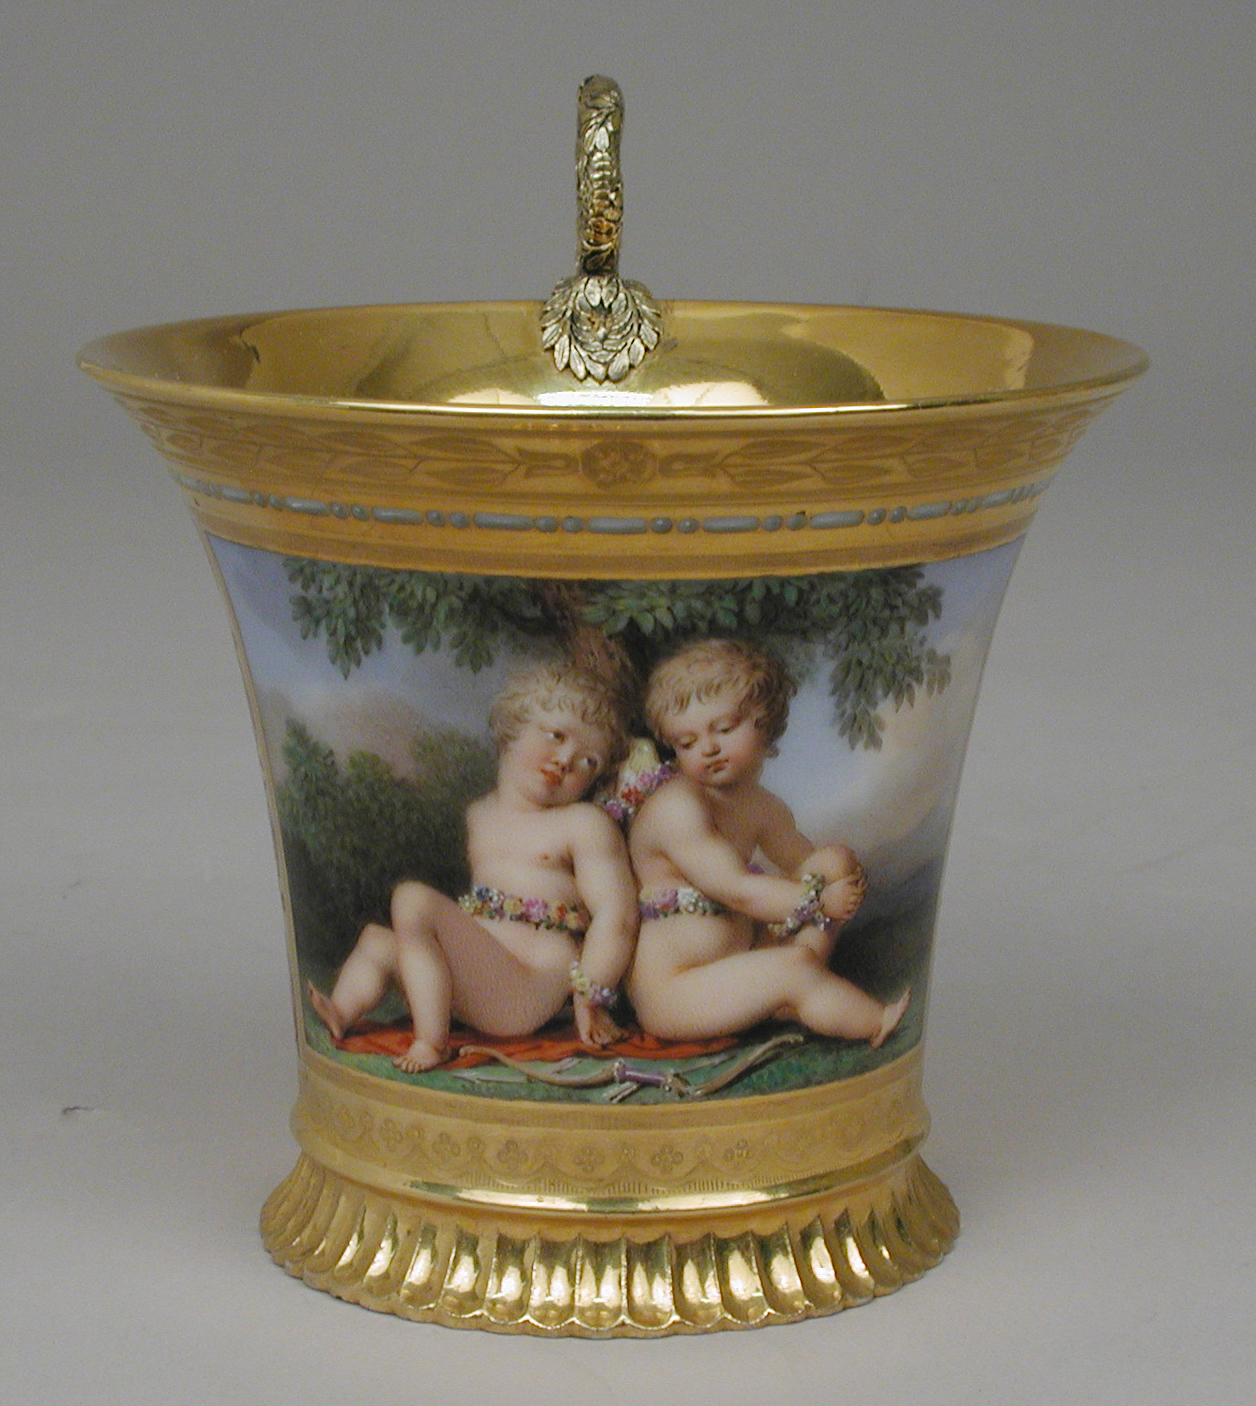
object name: cup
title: Cup (tasse Jasmin), part of Breakfast Service (déjeuner)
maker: sèvres manufactory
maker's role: manufactory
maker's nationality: french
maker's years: 1740-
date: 1813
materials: hard paste porcelain, silver gilt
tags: cupid